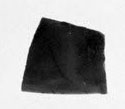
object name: fragment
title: Fragment of a Bowl (Study Collection)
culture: chinese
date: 960-1279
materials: ceramic glaze, ceramic, glaze